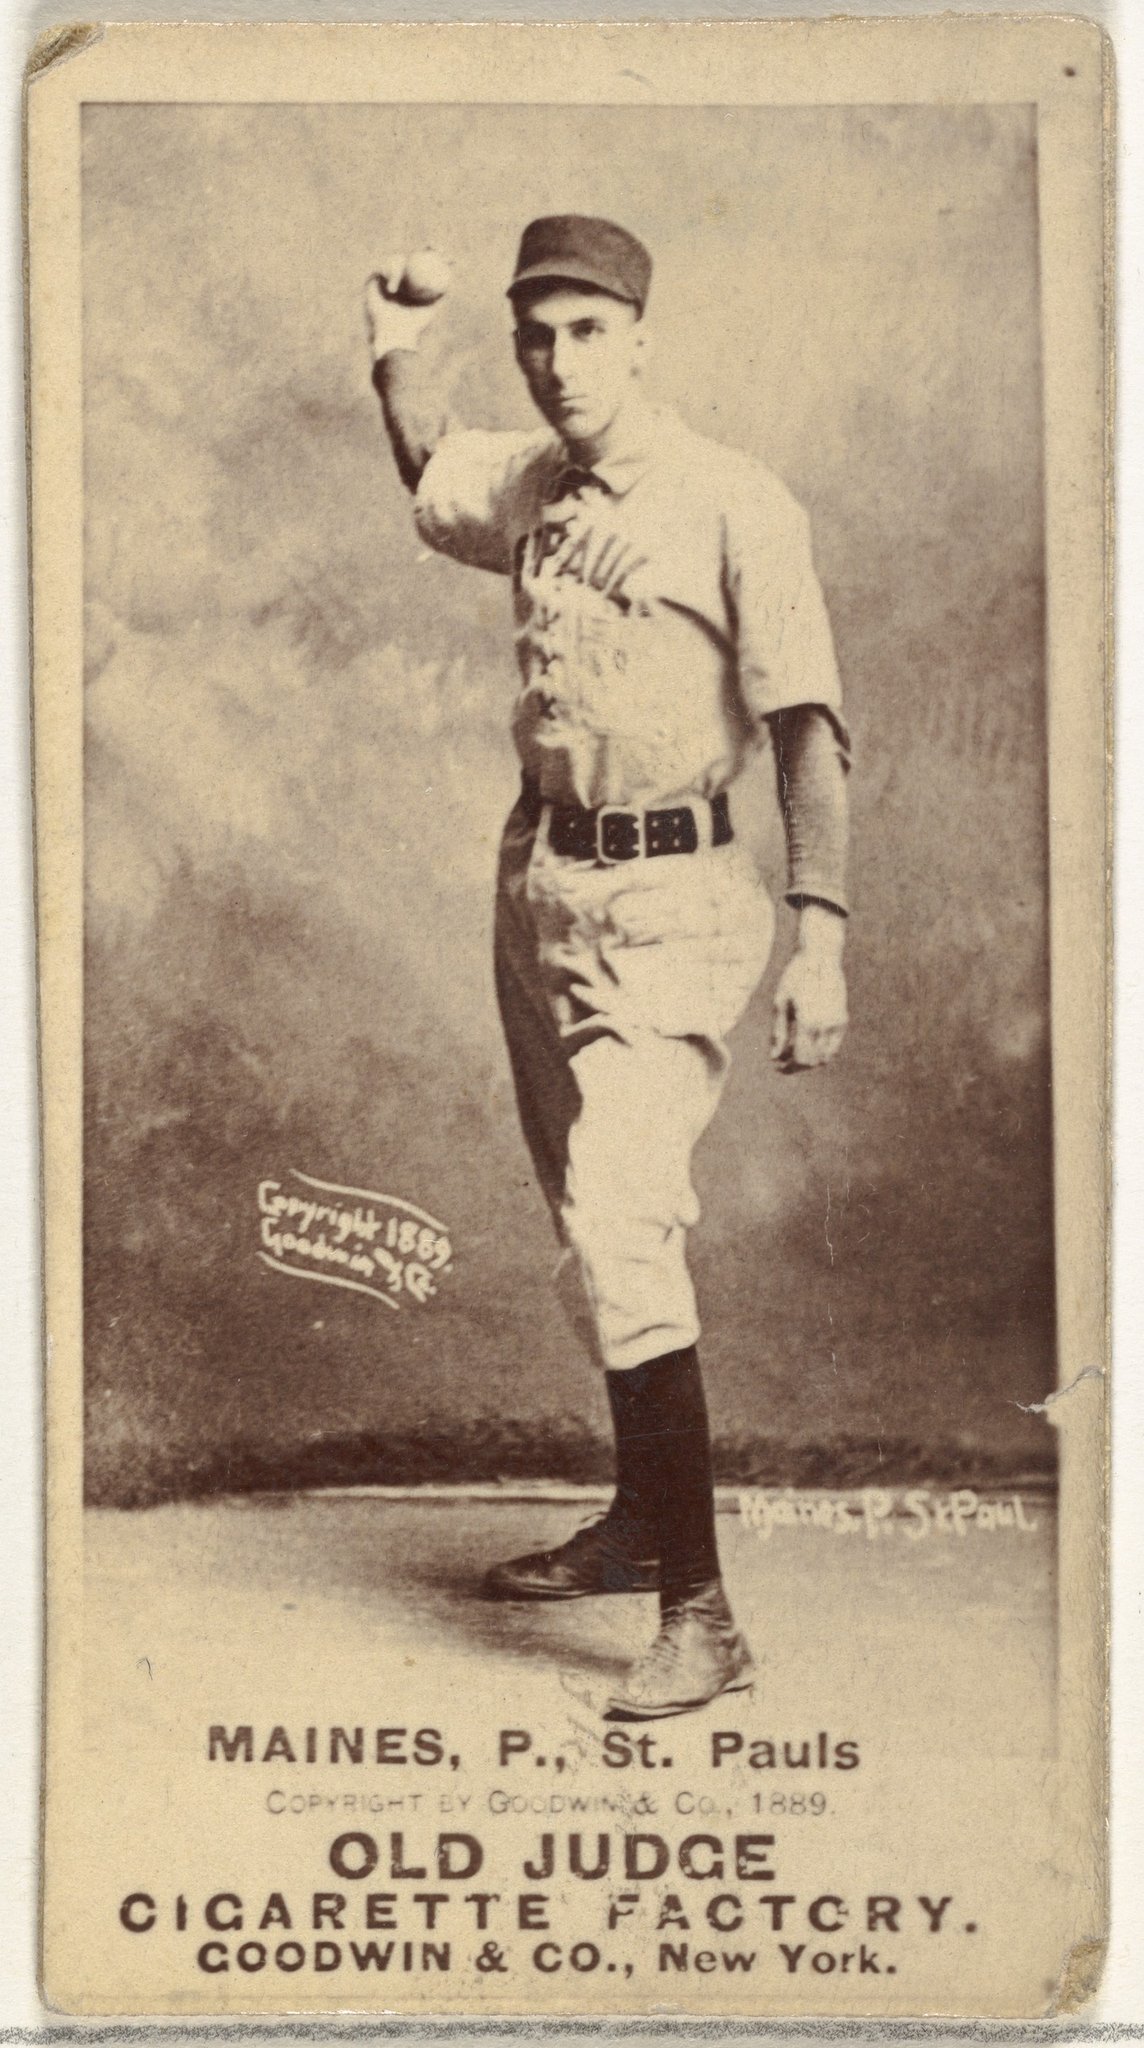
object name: baseball card, photograph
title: Willard Eben Mains, Pitcher, St. Paul Apostles, from the Old Judge series (N172) for Old Judge Cigarettes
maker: goodwin & company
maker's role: publisher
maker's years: 1850-1950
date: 1889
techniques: albumen silver print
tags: men,portraits,baseball,athletes